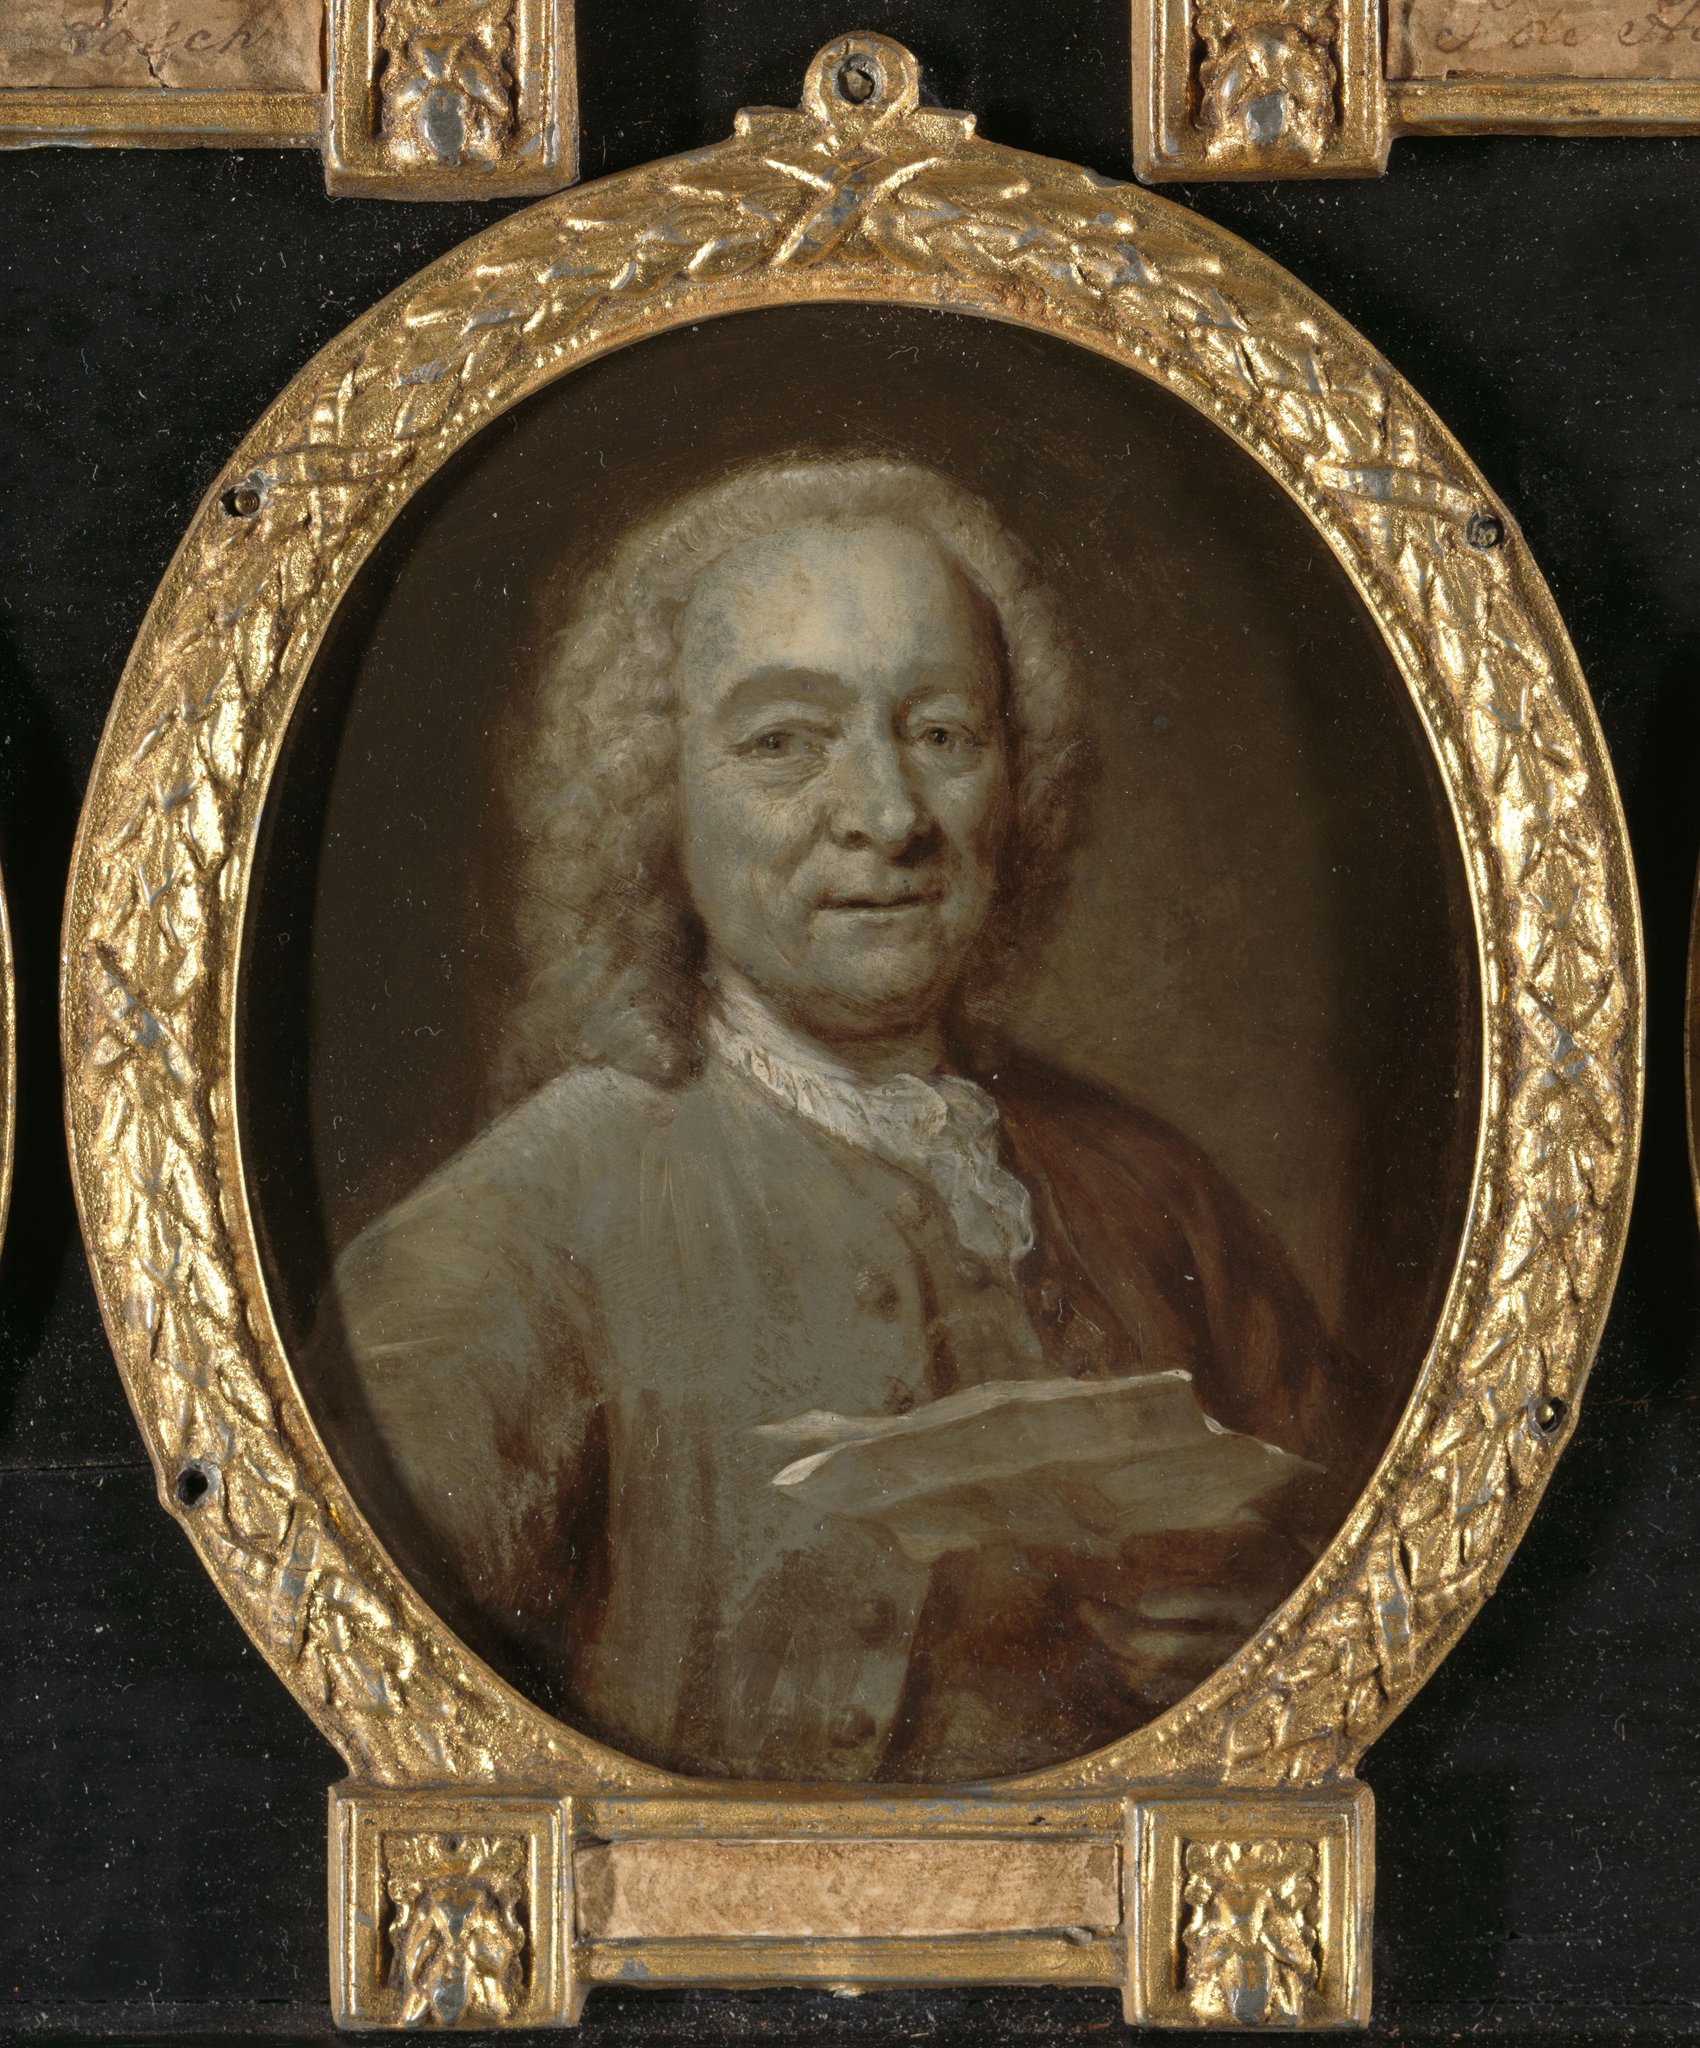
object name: painting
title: Portrait of Jan Harmensz de Marre (1696-1763). Seaman, Poet and Director of the Amsterdam Theater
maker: jan maurits quinkhard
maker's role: draughtsman, painter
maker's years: 1688-1772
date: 1732-1771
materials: copper, oil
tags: portrait of a writer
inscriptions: inscription: ‘De Marre / 8/23 1696.’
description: Portret van Jan Harmensz de Marre (1696-1763). Zeeman, dichter en directeur van de Amsterdamse schouwburg. Buste in ovaal, iets naar rechts, het gezicht bijna aanziend, een blad papier in de linkerhand. Onderdeel van een verzameling portretten van Nederlandse dichters.